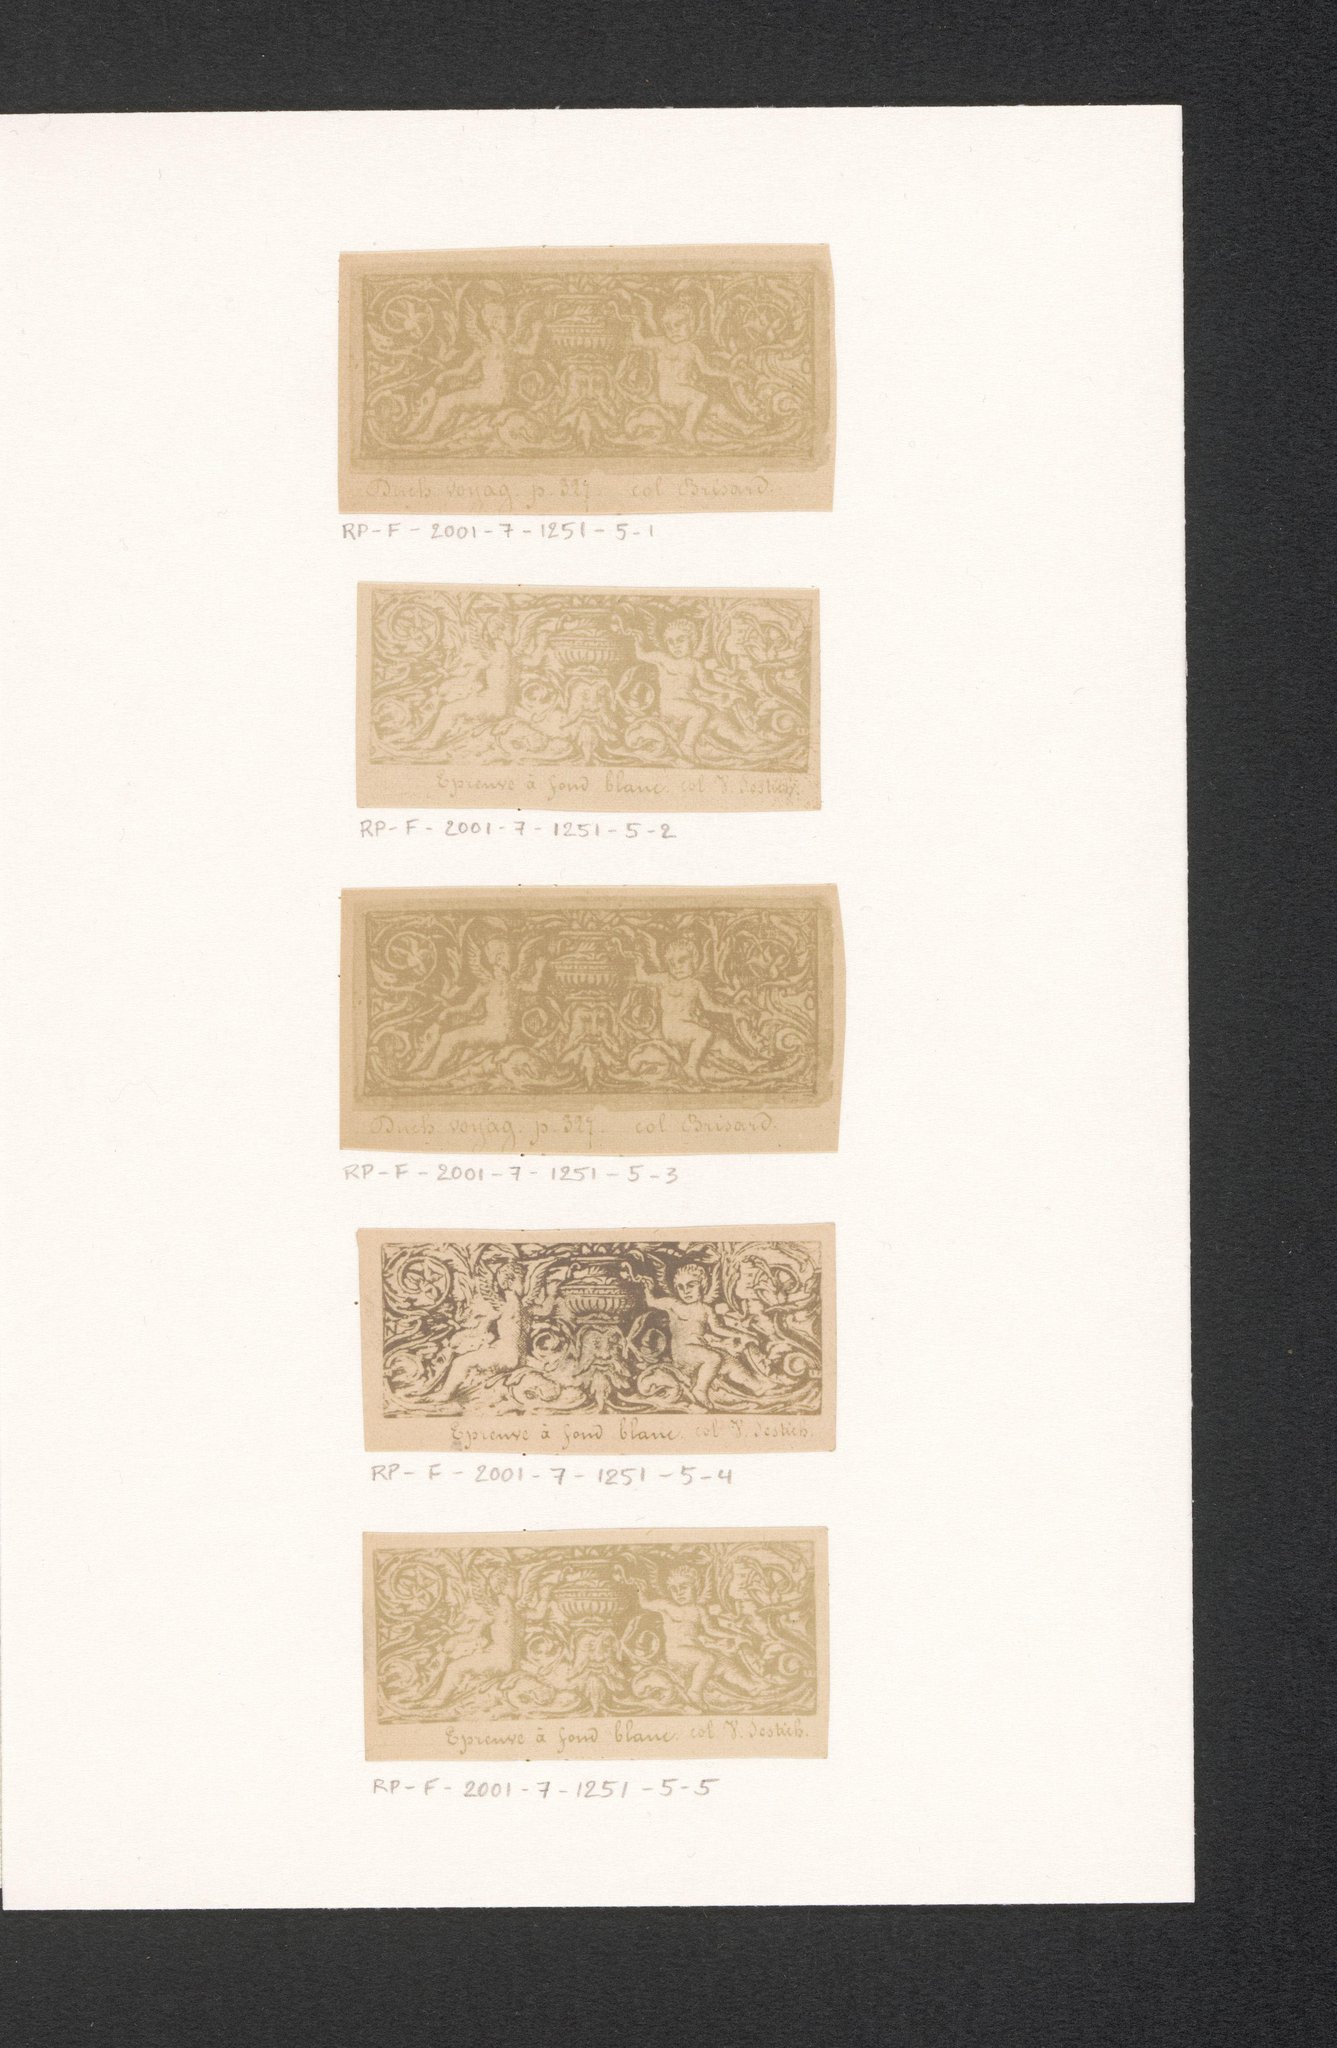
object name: page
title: Fotoreproductie van een prent van groteske ornamenten en twee putti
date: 1852-1857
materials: photographic support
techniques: salted paper print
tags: ornament ~ grotesque, cupids: 'amores', 'amoretti', 'putti'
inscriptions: inscription: ‘Duch. Voyag. p. 327. col. Brisard.’